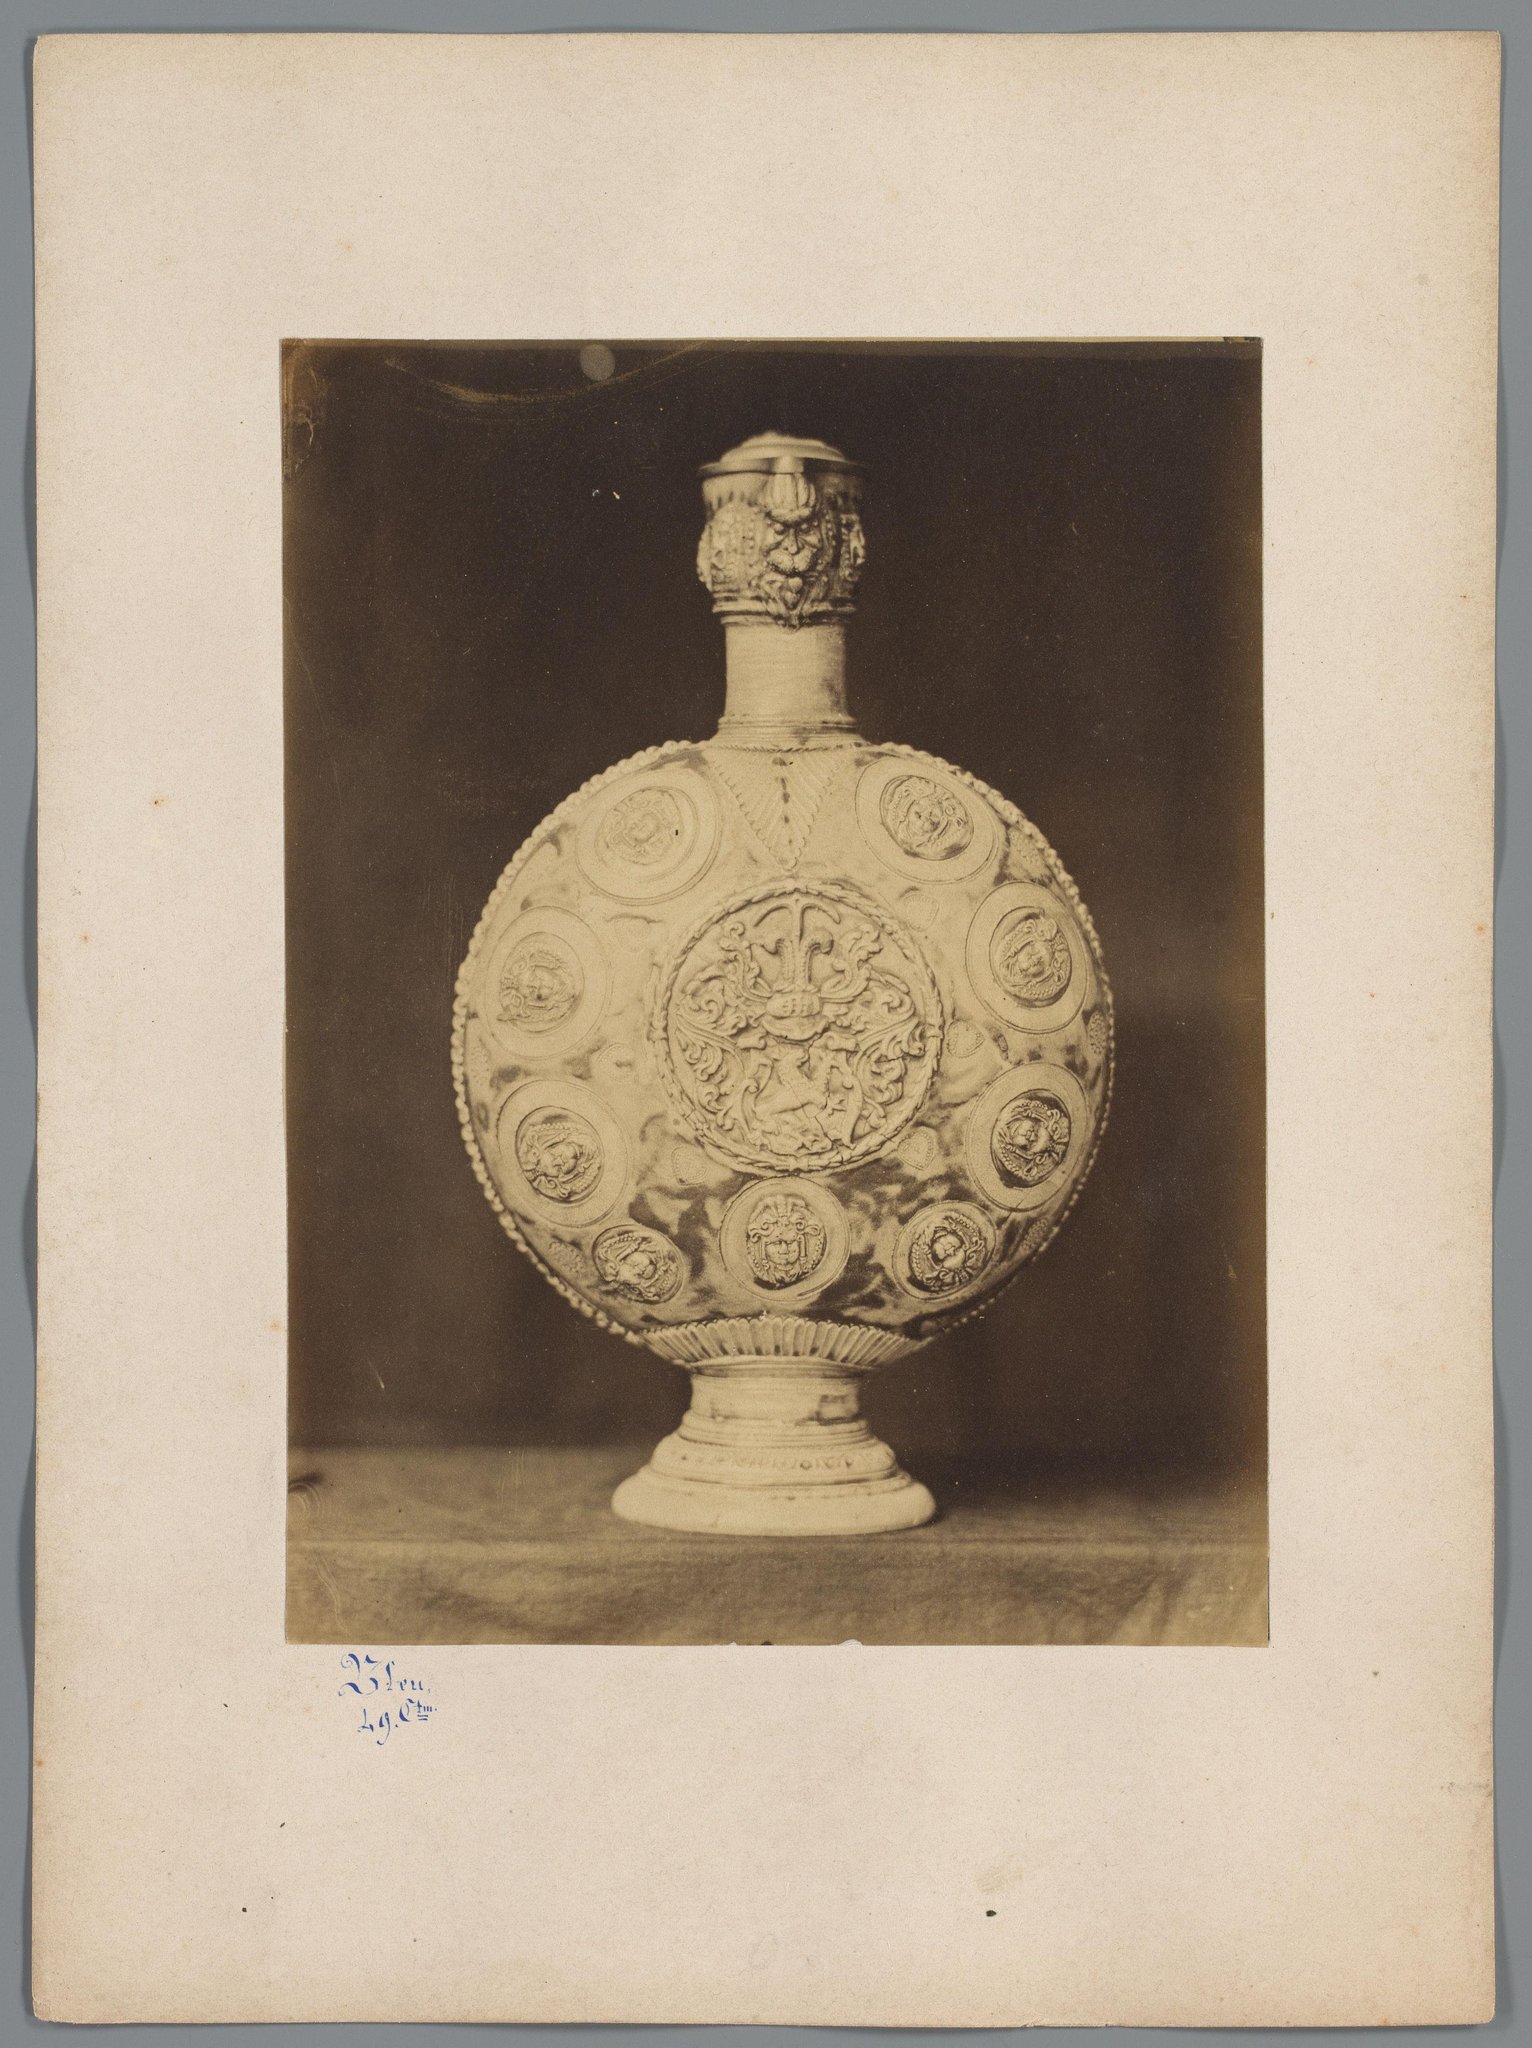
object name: photograph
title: Aardewerken vaas uit de collectie van W. de Weckherlin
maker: Anonymous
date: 1860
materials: paper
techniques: albumen print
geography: the hague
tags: container of ceramics: jar, jug, pot, vase, the hague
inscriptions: inscription: ‘Bleu./ 49 Ctm.’